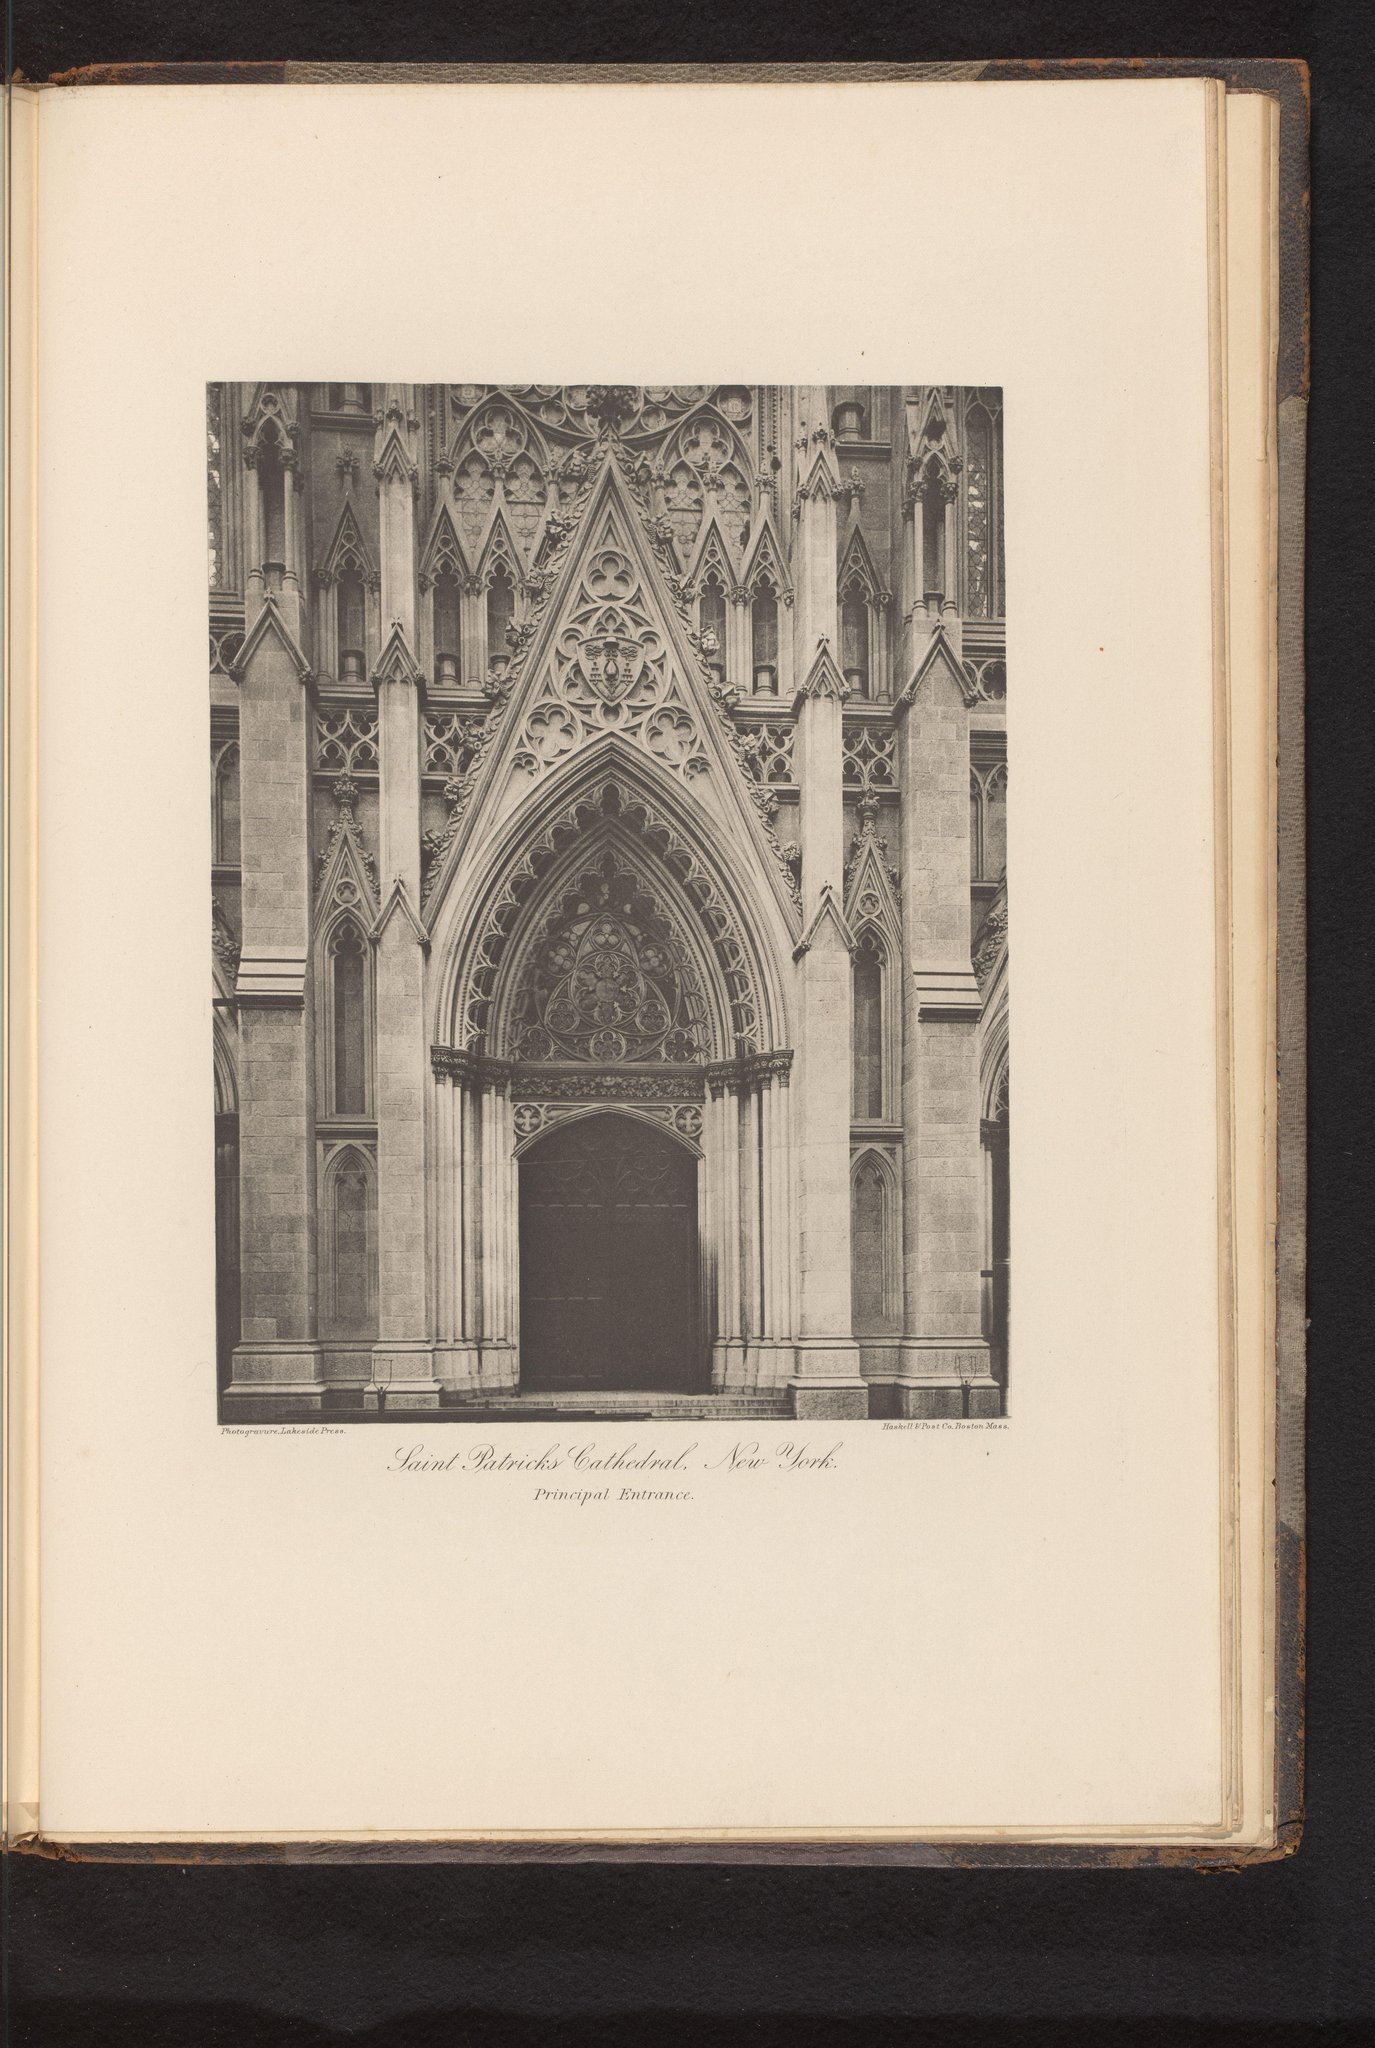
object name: page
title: Portaal van de Saint Patrick's Cathedral te New York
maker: Anonymous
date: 1881-1886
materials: paper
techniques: photograph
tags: parts of church exterior and annexes: portal